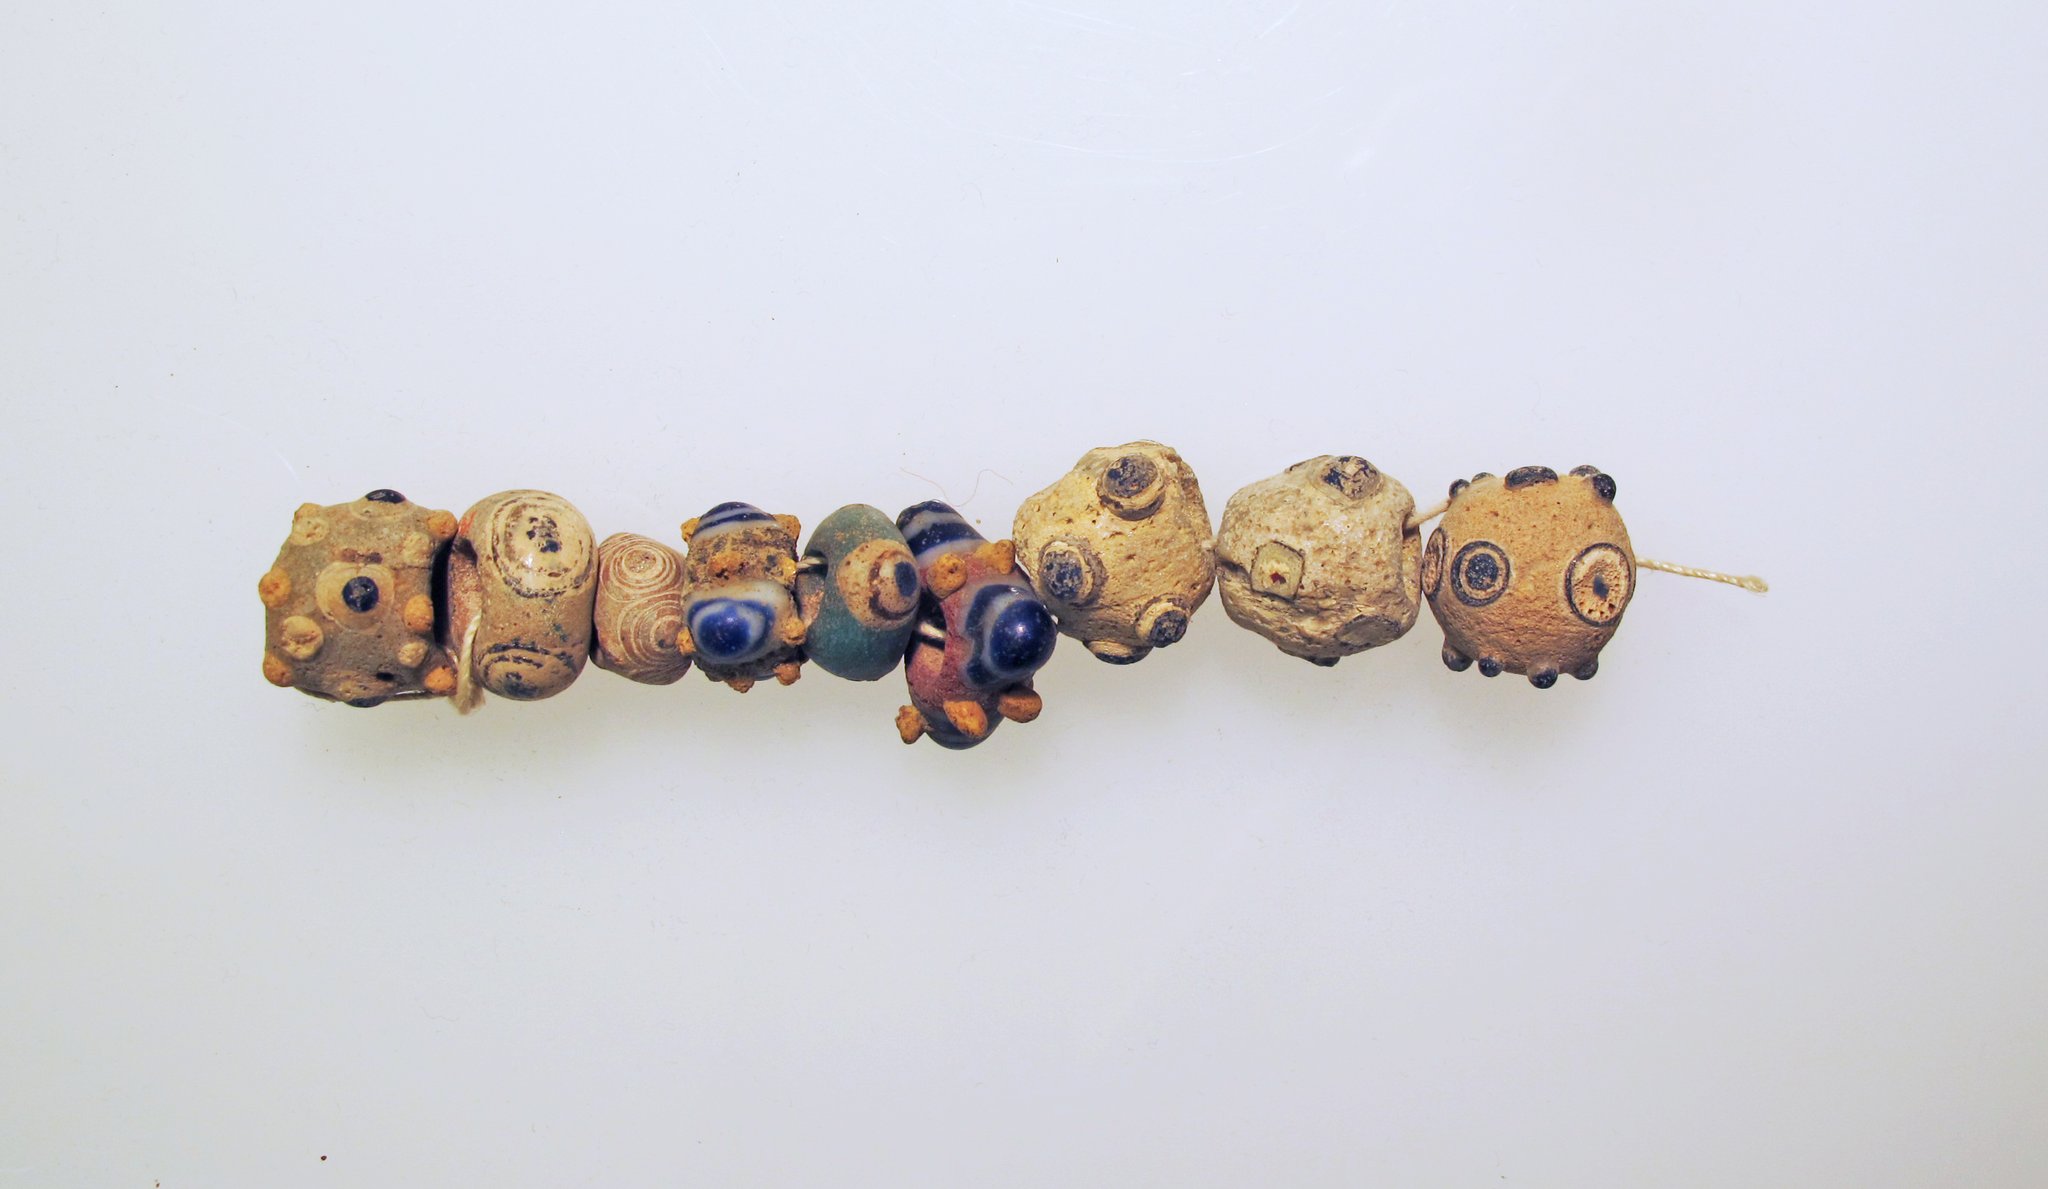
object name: bead, 9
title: Glass eye beads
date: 7000 BCE-330 CE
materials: glass